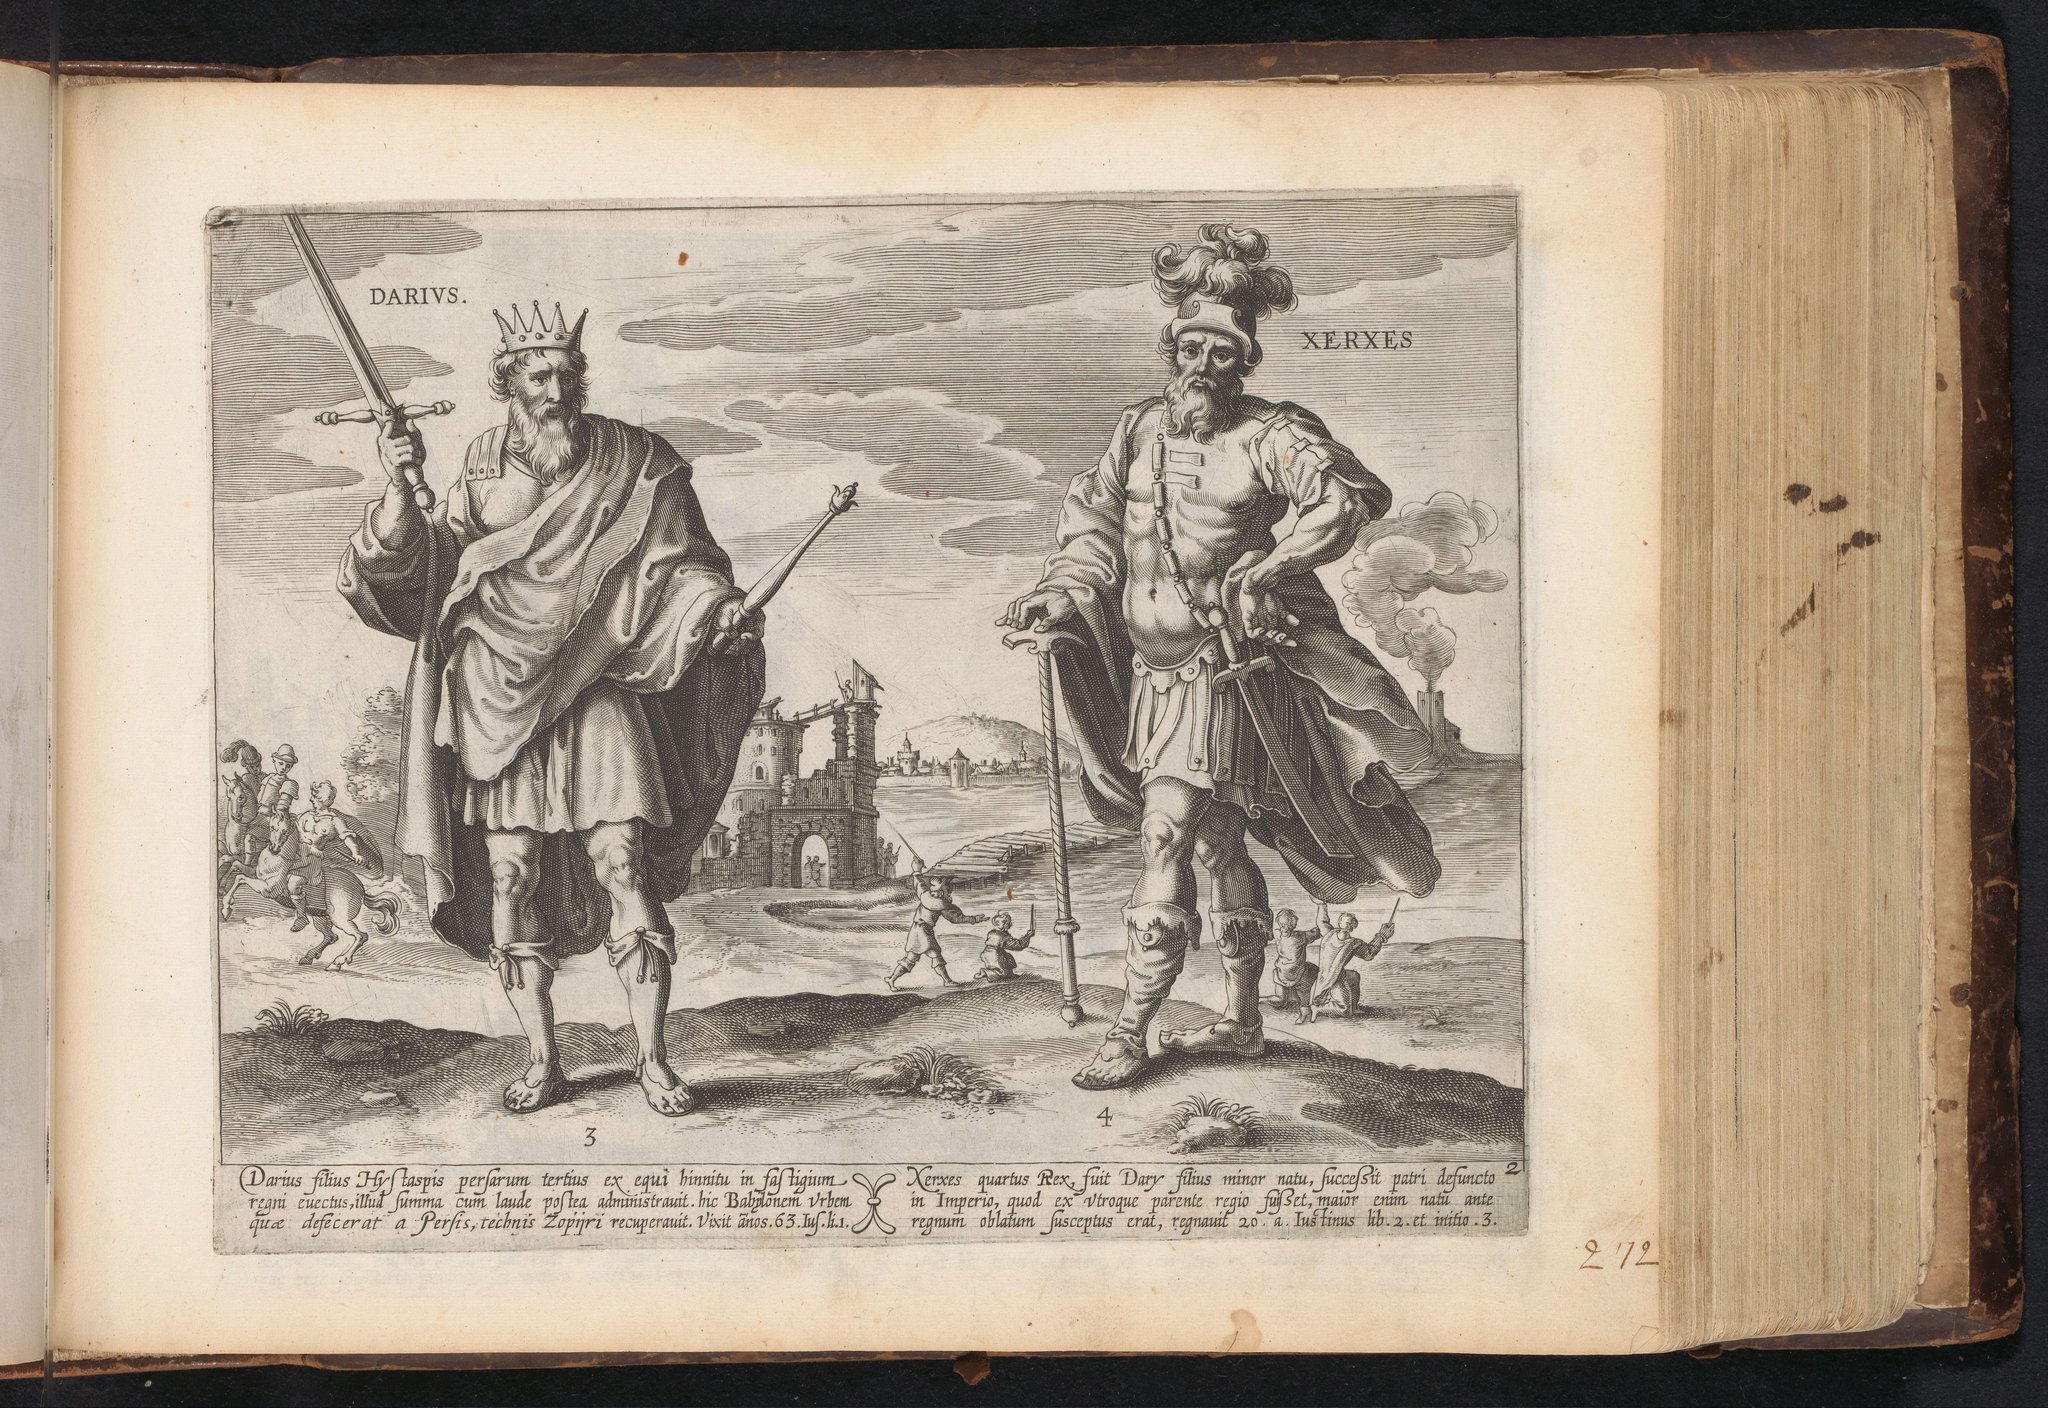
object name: album leaf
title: Den Grooten Figuer-Bibel (...)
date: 1643-1646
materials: paper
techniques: engraving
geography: alkmaar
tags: (story of) darius, king of persia - portrait of person from classical history, darius is chosen king of persia; his horse is the first to neigh at sunrise, male persons from classical history, ruler, sovereign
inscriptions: number: ‘272’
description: Links staat koning Darius I van Perzië met een scepter en zwaard in zijn handen. Op de achtergrond is te zien hoe Darius tot koning van Perzië werd gekozen. Zijn paard hinnikt als eerste bij zonsopgang. Rechts koning Xerxes van Perzië staande met een hand op een pikhouweel. Op de achtergrond is te zien hoe de mannen van Xerxes de Hellespont zweepslagen geven. Dit deden zij in opdracht van Xerxes nadat de gebouwde bruggen over de Hellespont door storm en het water waren vernield. Onder de voorstelling twee drieregelige teksten in het Latijn. Deze prent maakt deel uit van een album.